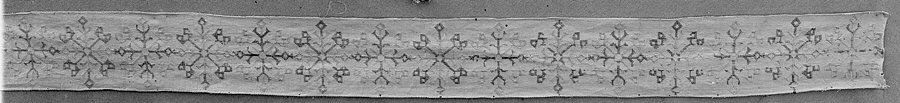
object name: border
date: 1701-1800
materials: linen, silk